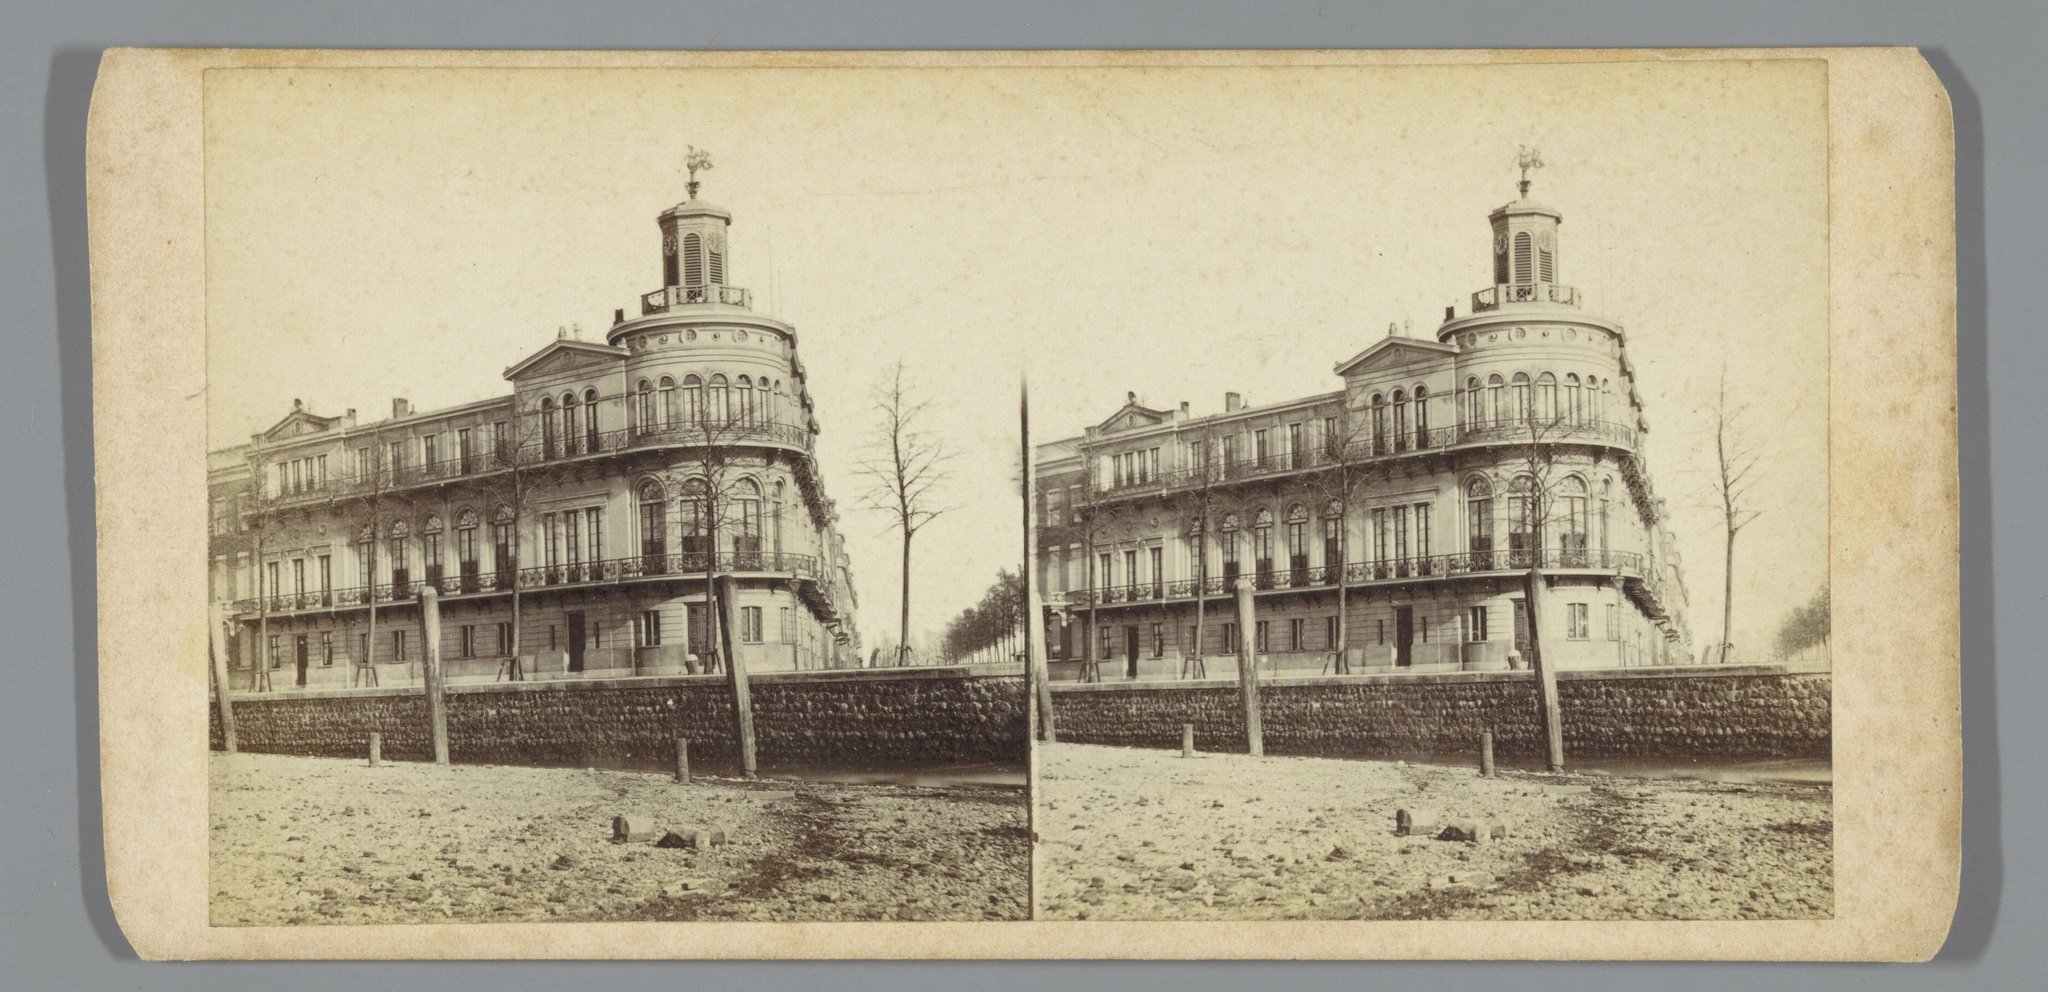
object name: stereograph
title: Vues de Hollande. Rotterdam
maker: pieter oosterhuis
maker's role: draughtsman, print maker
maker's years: 1816-1885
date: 1859-1865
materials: cardboard, paper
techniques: albumen print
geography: rotterdam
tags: club, meeting place, rotterdam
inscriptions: number: ‘No. 104.’